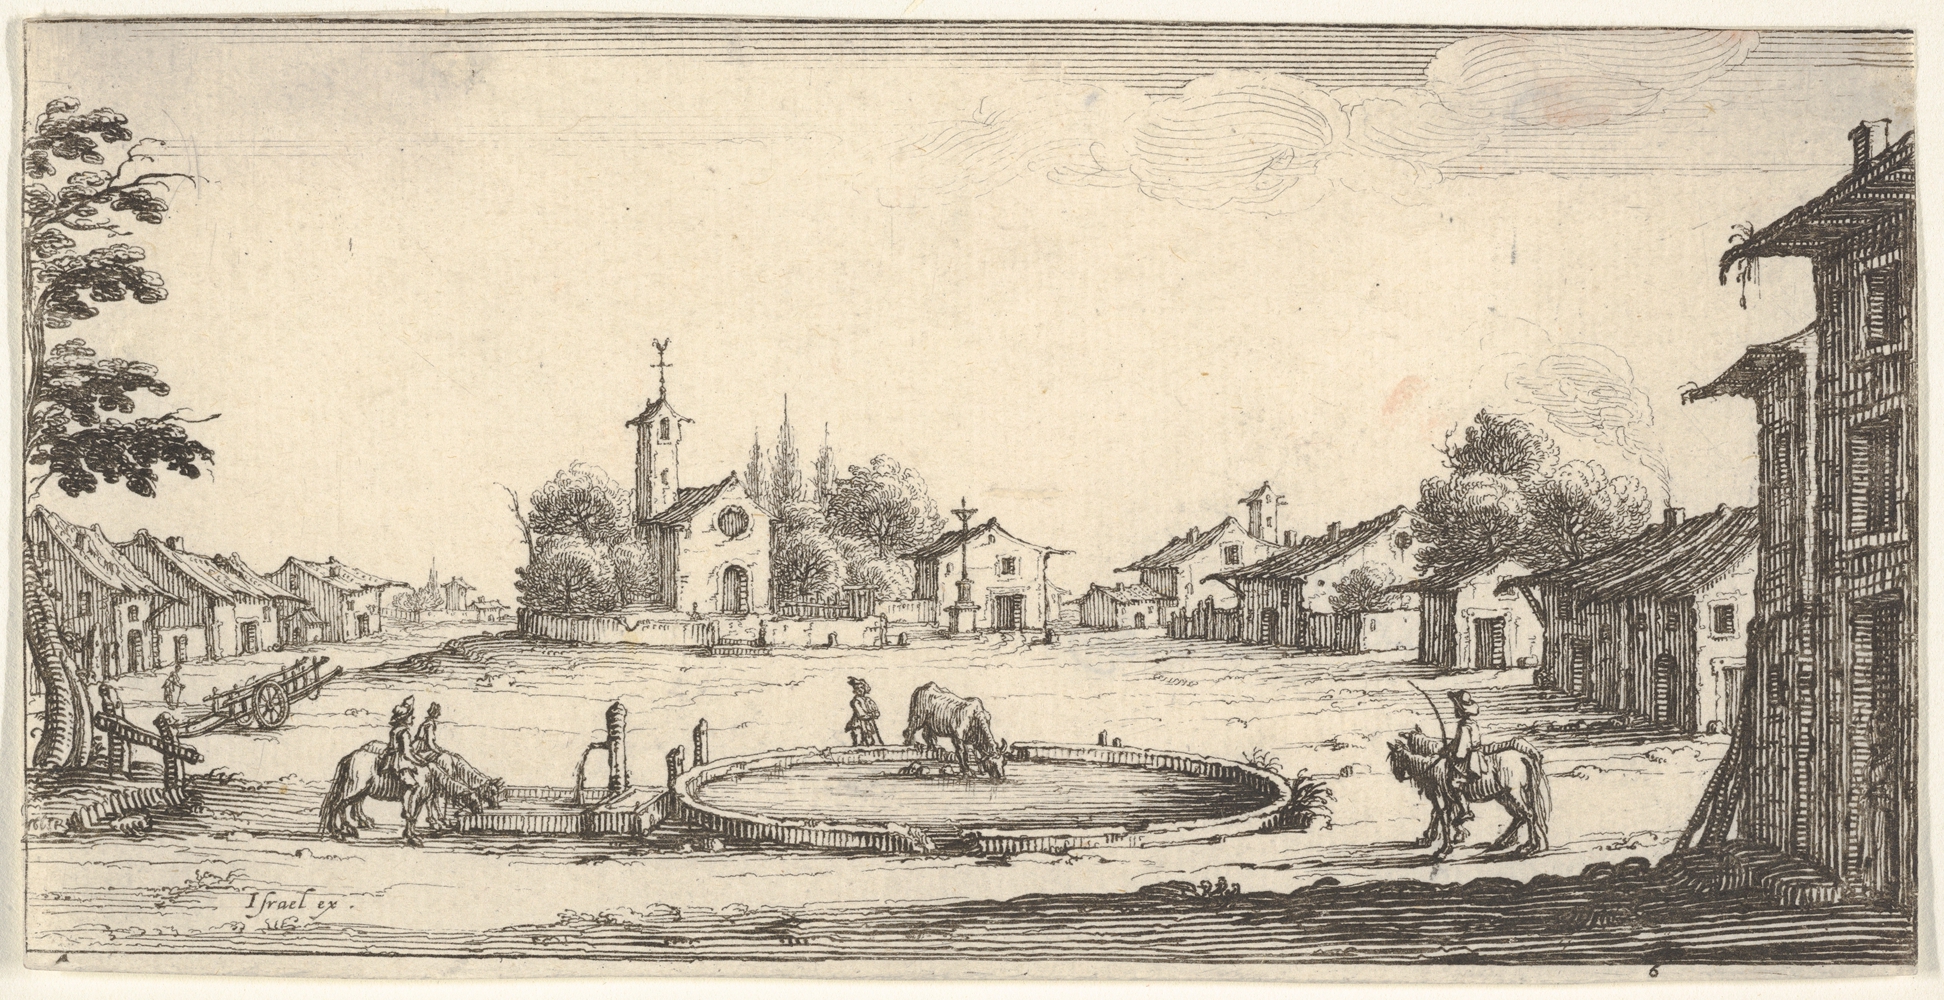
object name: print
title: Plate 6: view of a village with a horse trough in center, horses and houses to either side, a church in center background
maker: françois collignon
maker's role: artist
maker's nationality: french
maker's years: 1605-1687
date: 1636-1661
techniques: etching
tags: human figures,houses,churches,villages,horses